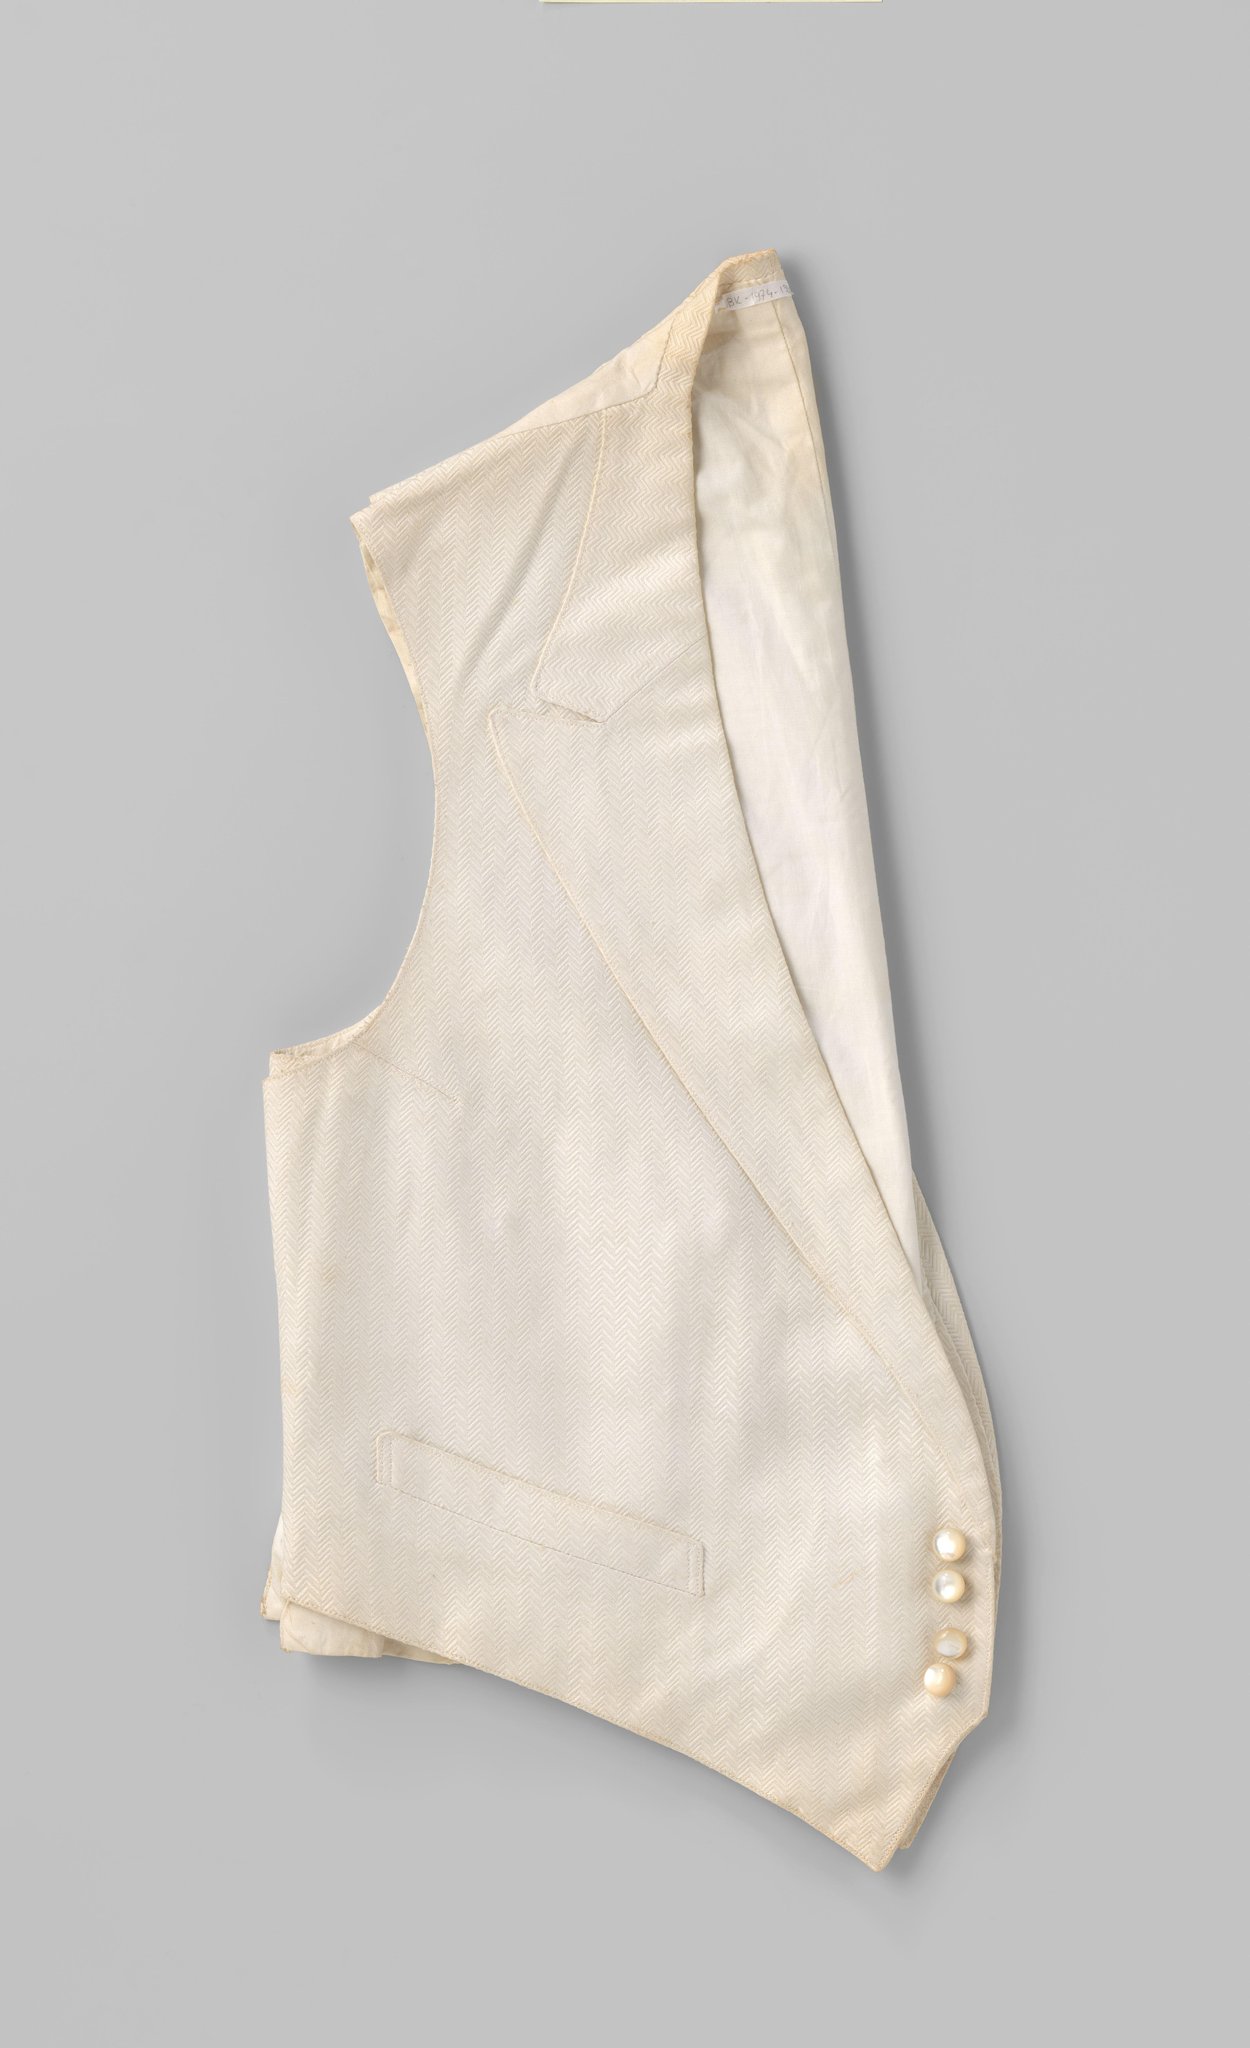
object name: vest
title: Vest met drie steekzakken, laag doorlopende reverskraag en vier parelmoeren knopen van crème katoen (?) met ingeweven schuinstaande streepjesranden; voering en rug wit katoen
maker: Anonymous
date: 1930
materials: cotton, mother of pearl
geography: netherlands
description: Rokvest van wit katoen. Katoen geweven in gebroken keper. Kort vest met puntig gesneden ondereinden. Lage, puntige revers, tegen de schoudernaad stuitend. Eén rij van bolle, parelmoeren knoopjes. Drie schuine steekzakken, meelopend met de pandpuntjes. Rug en voering van wit linnen, binnenzak in de voering.